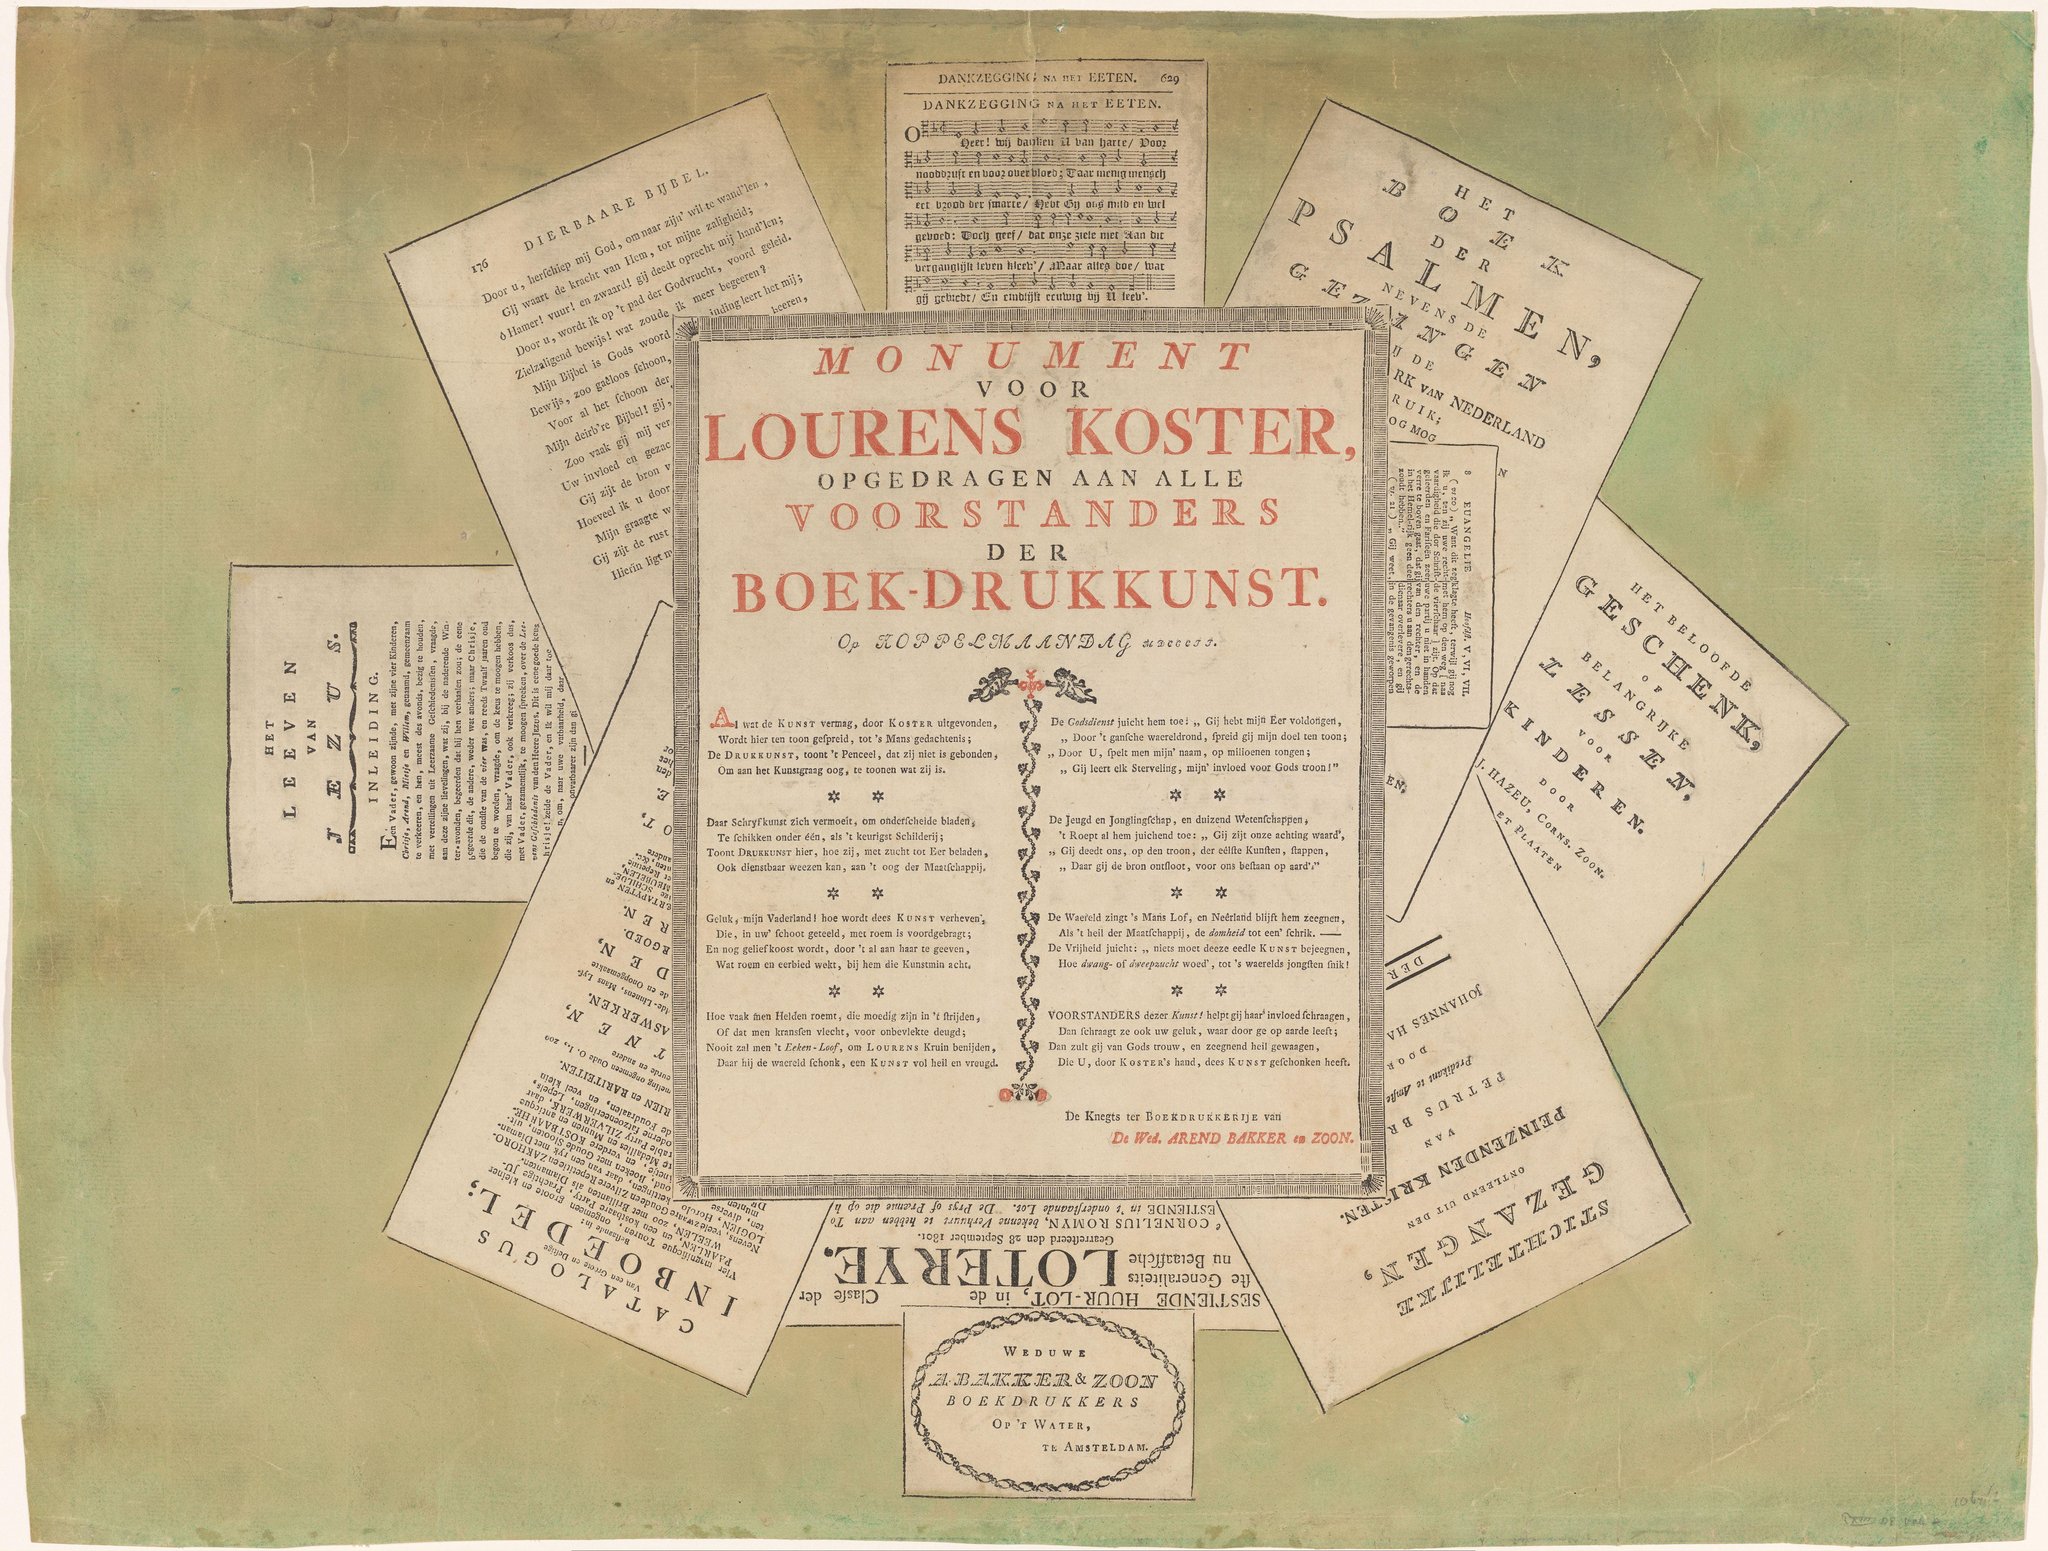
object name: print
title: Monument voor Lourens Koster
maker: Anonymous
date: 1803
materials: paper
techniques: hand coloring, letterpress printing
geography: amsterdam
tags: haarlem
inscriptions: watermark: ‘D & C Blauw / D & C B’, collector's mark: Lugt 2228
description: Koppermaandagprent door de gezellen van boekdrukkerij van de Weduwe Arend Bakker en Zoon, ter ere van Koppermaandag 1802.